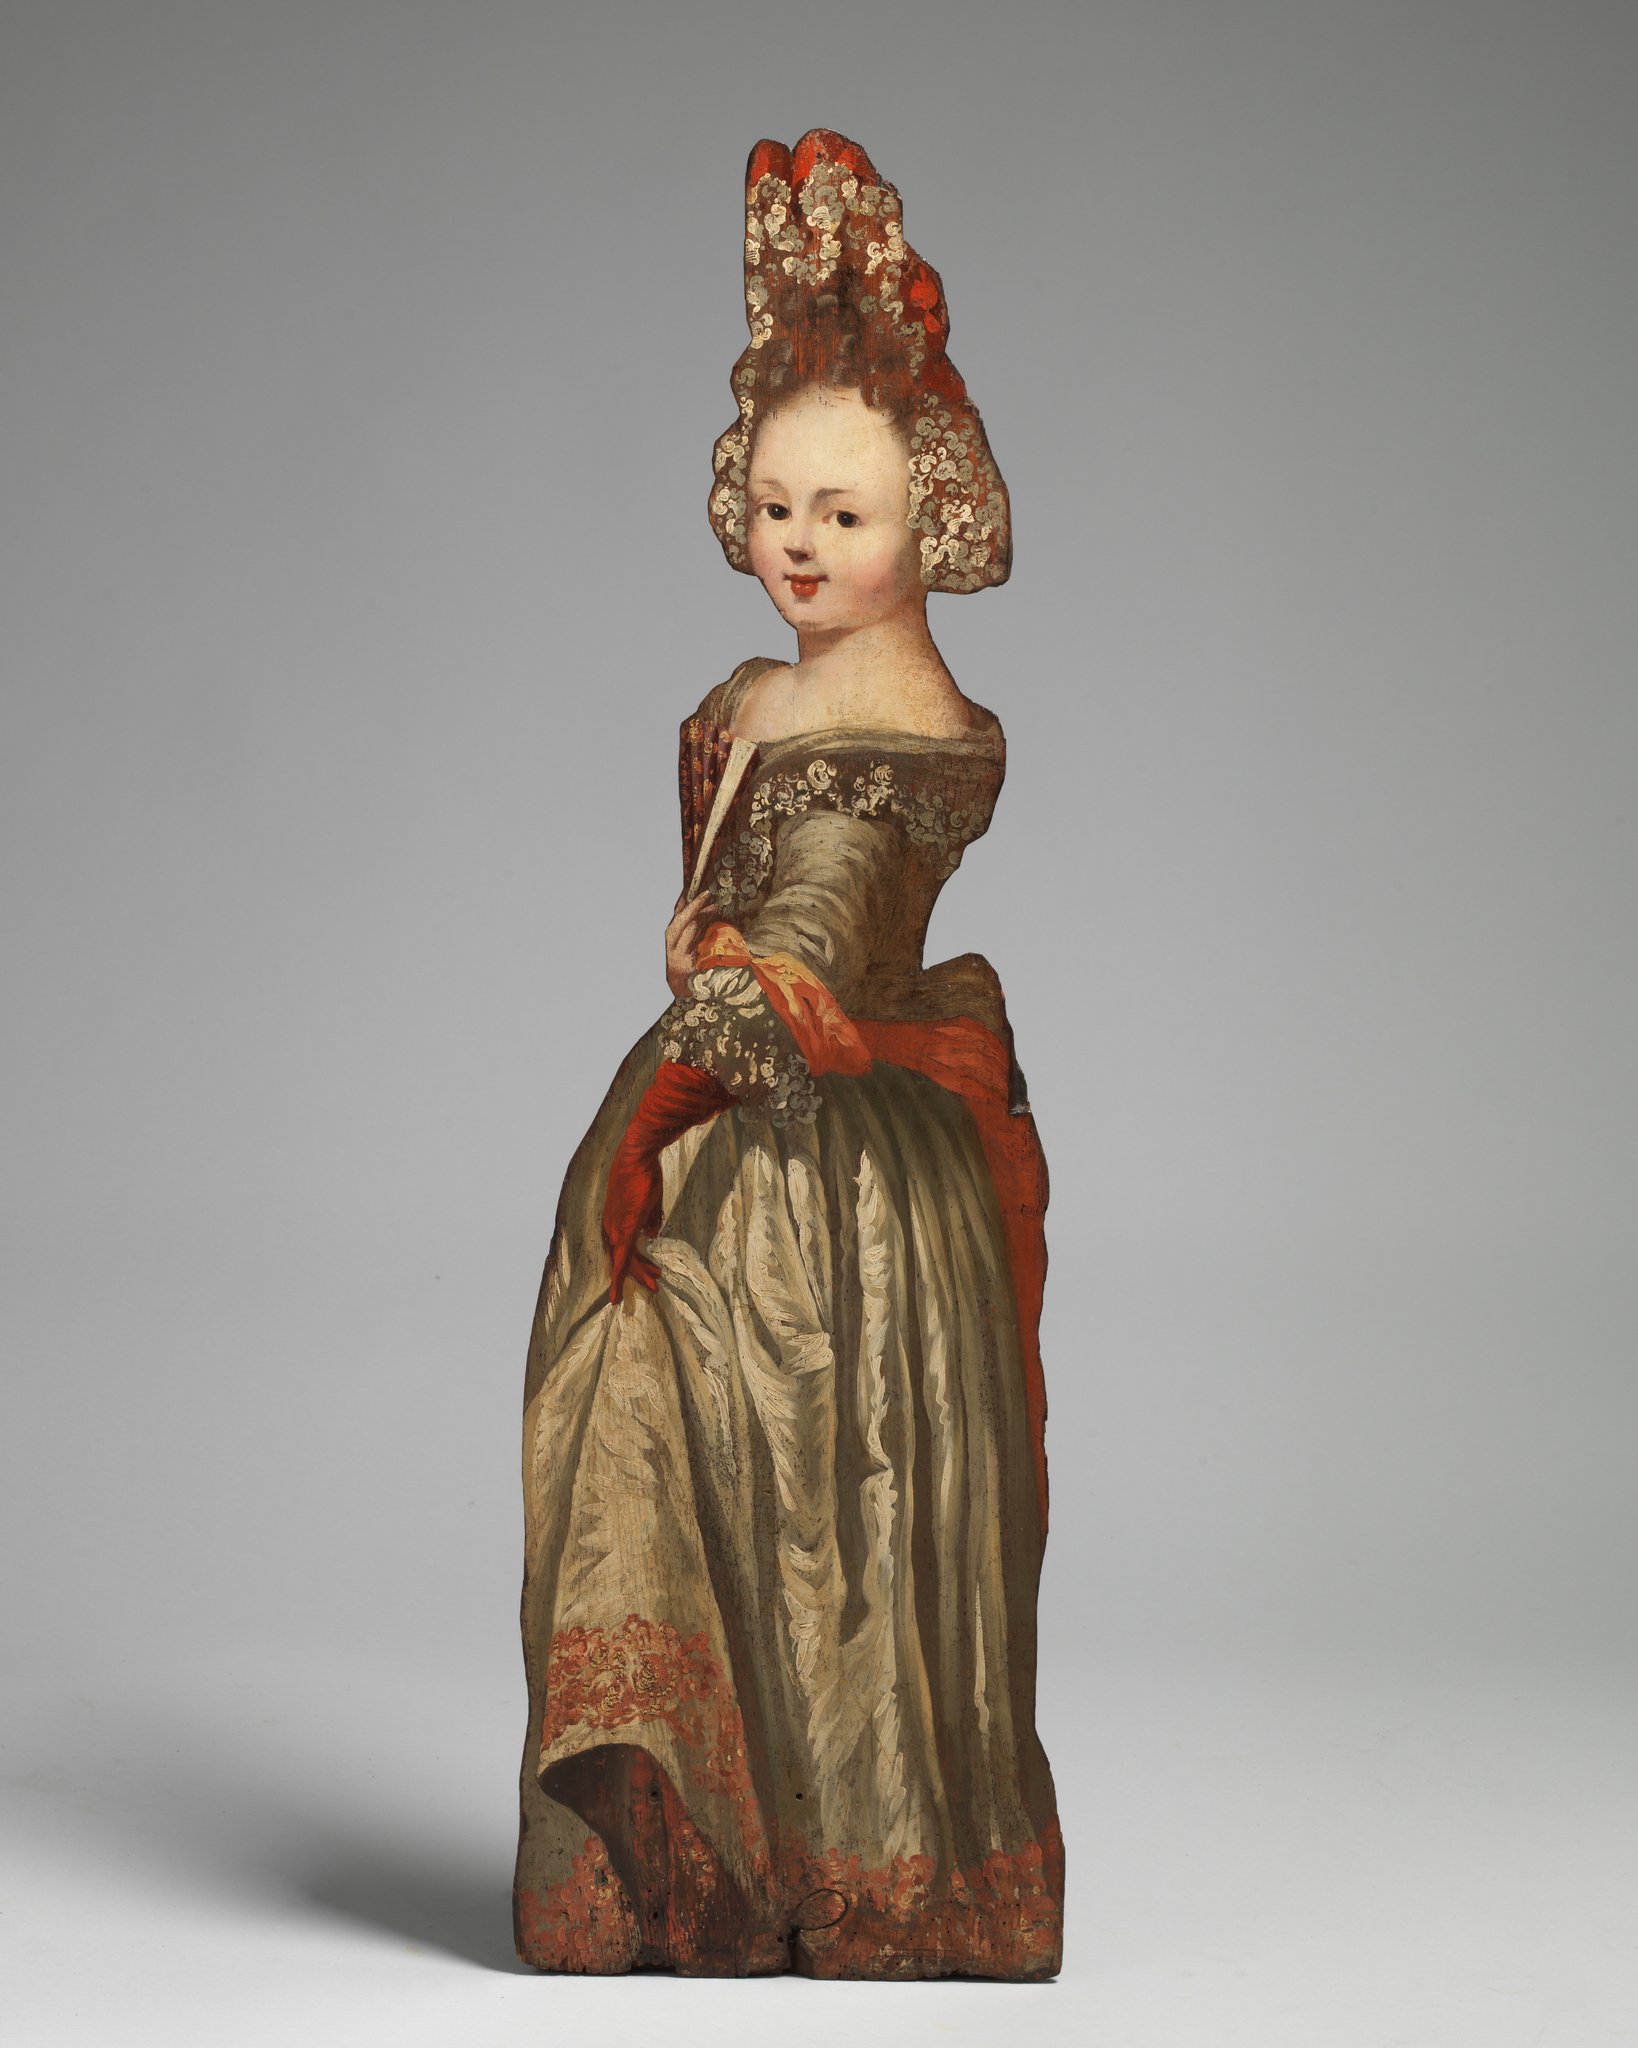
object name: dummy board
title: Girl dummy board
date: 1690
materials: varnish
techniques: painting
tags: girls